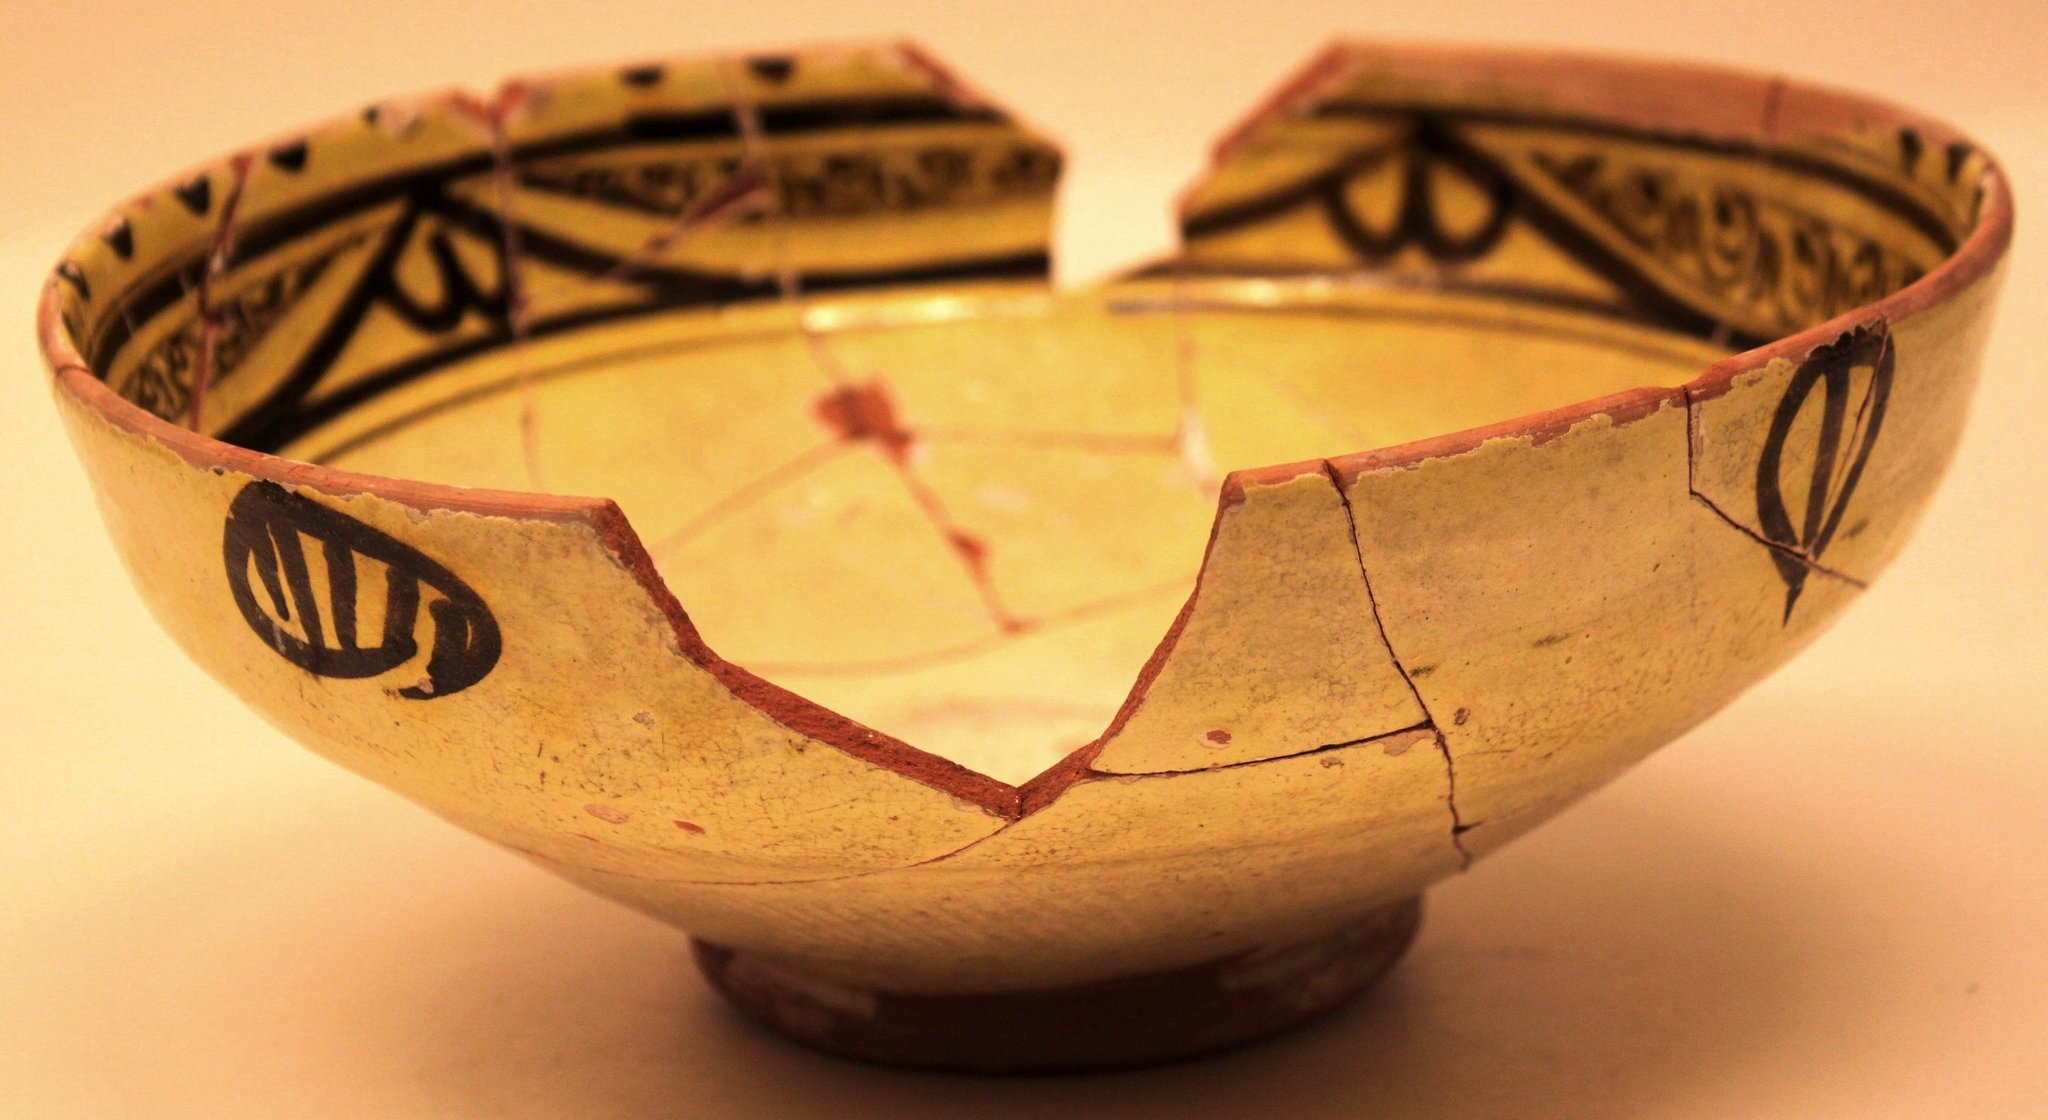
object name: bowl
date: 901-1000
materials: earthenware, glaze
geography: iran